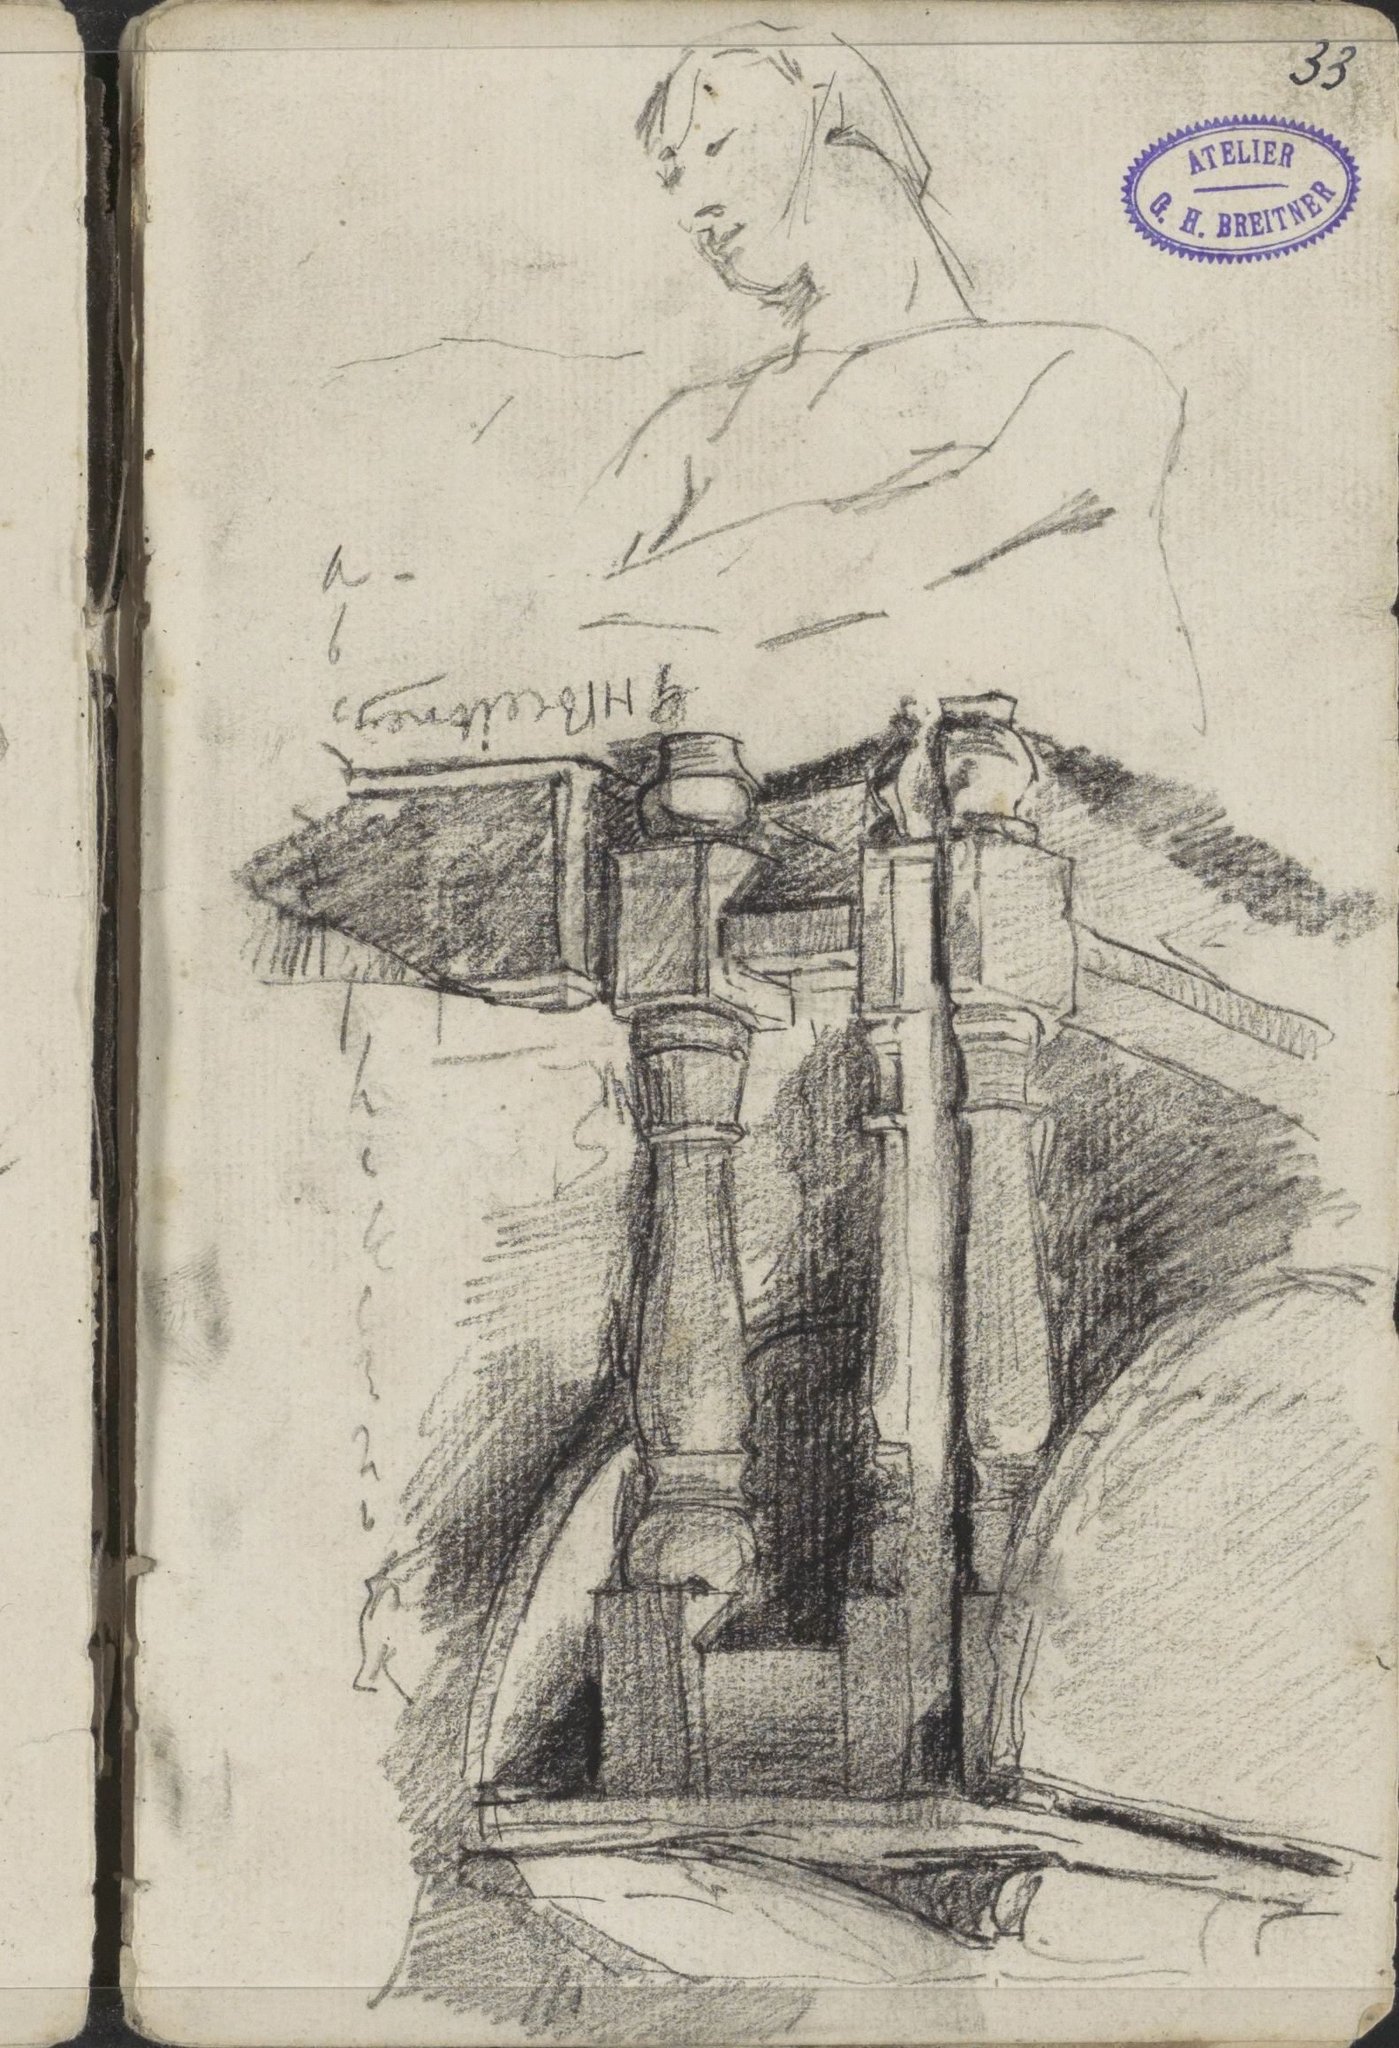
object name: sketchbook leaf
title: Figuurstudie en een boek op een tafel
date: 1880-1882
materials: chalk, paper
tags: adult man, book - mm - book open, table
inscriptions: workshop stamp: Lugt 291d, signature: ‘G H Breitner’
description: Blad 33 recto uit een schetsboek met 16 bladen.